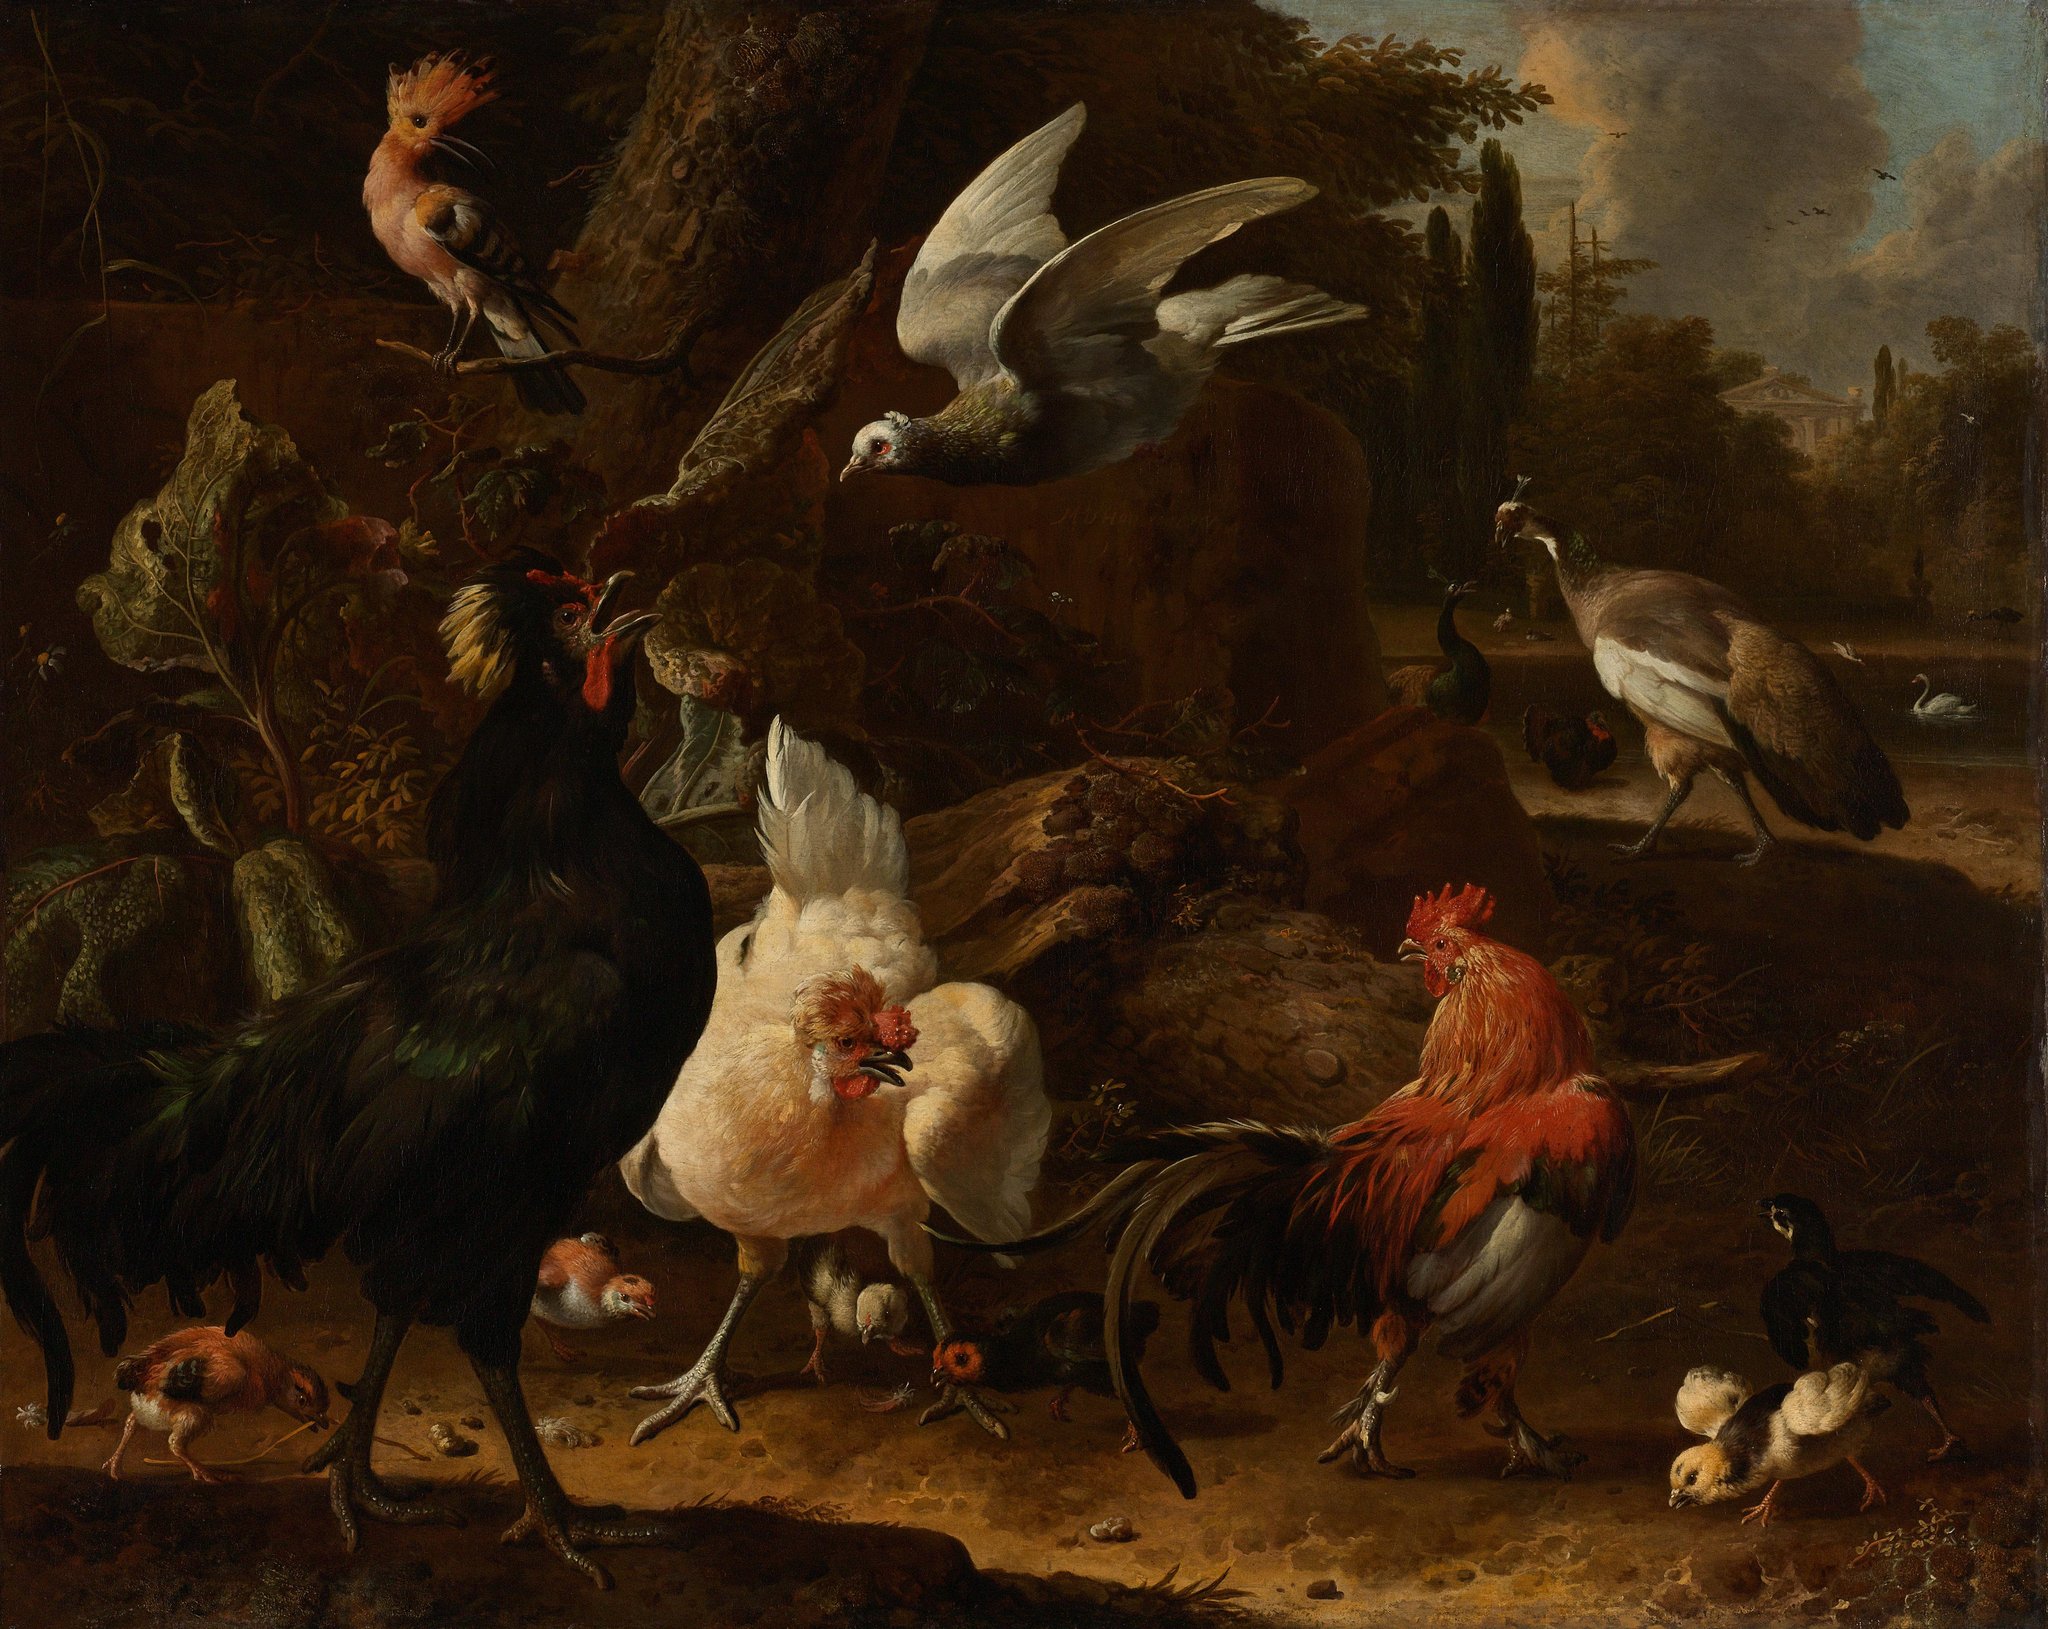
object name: painting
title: Birds in a Park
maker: melchior d hondecoeter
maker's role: draughtsman, painter, print maker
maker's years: 1636-1695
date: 1686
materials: canvas, oil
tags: birds, garden, fowl (cock, hen, chicken, etc.)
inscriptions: signature and date: ‘M D Hondecoeter A 1686’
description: Vogels in een park. Op de voorgrond twee hanen en een kip met haar kuikens. Links in een boom zit een hop, een duif komt aangevlogen. Rechts een pauw en in het verschiet nog een pauw, een kalkoen en een zwaan.